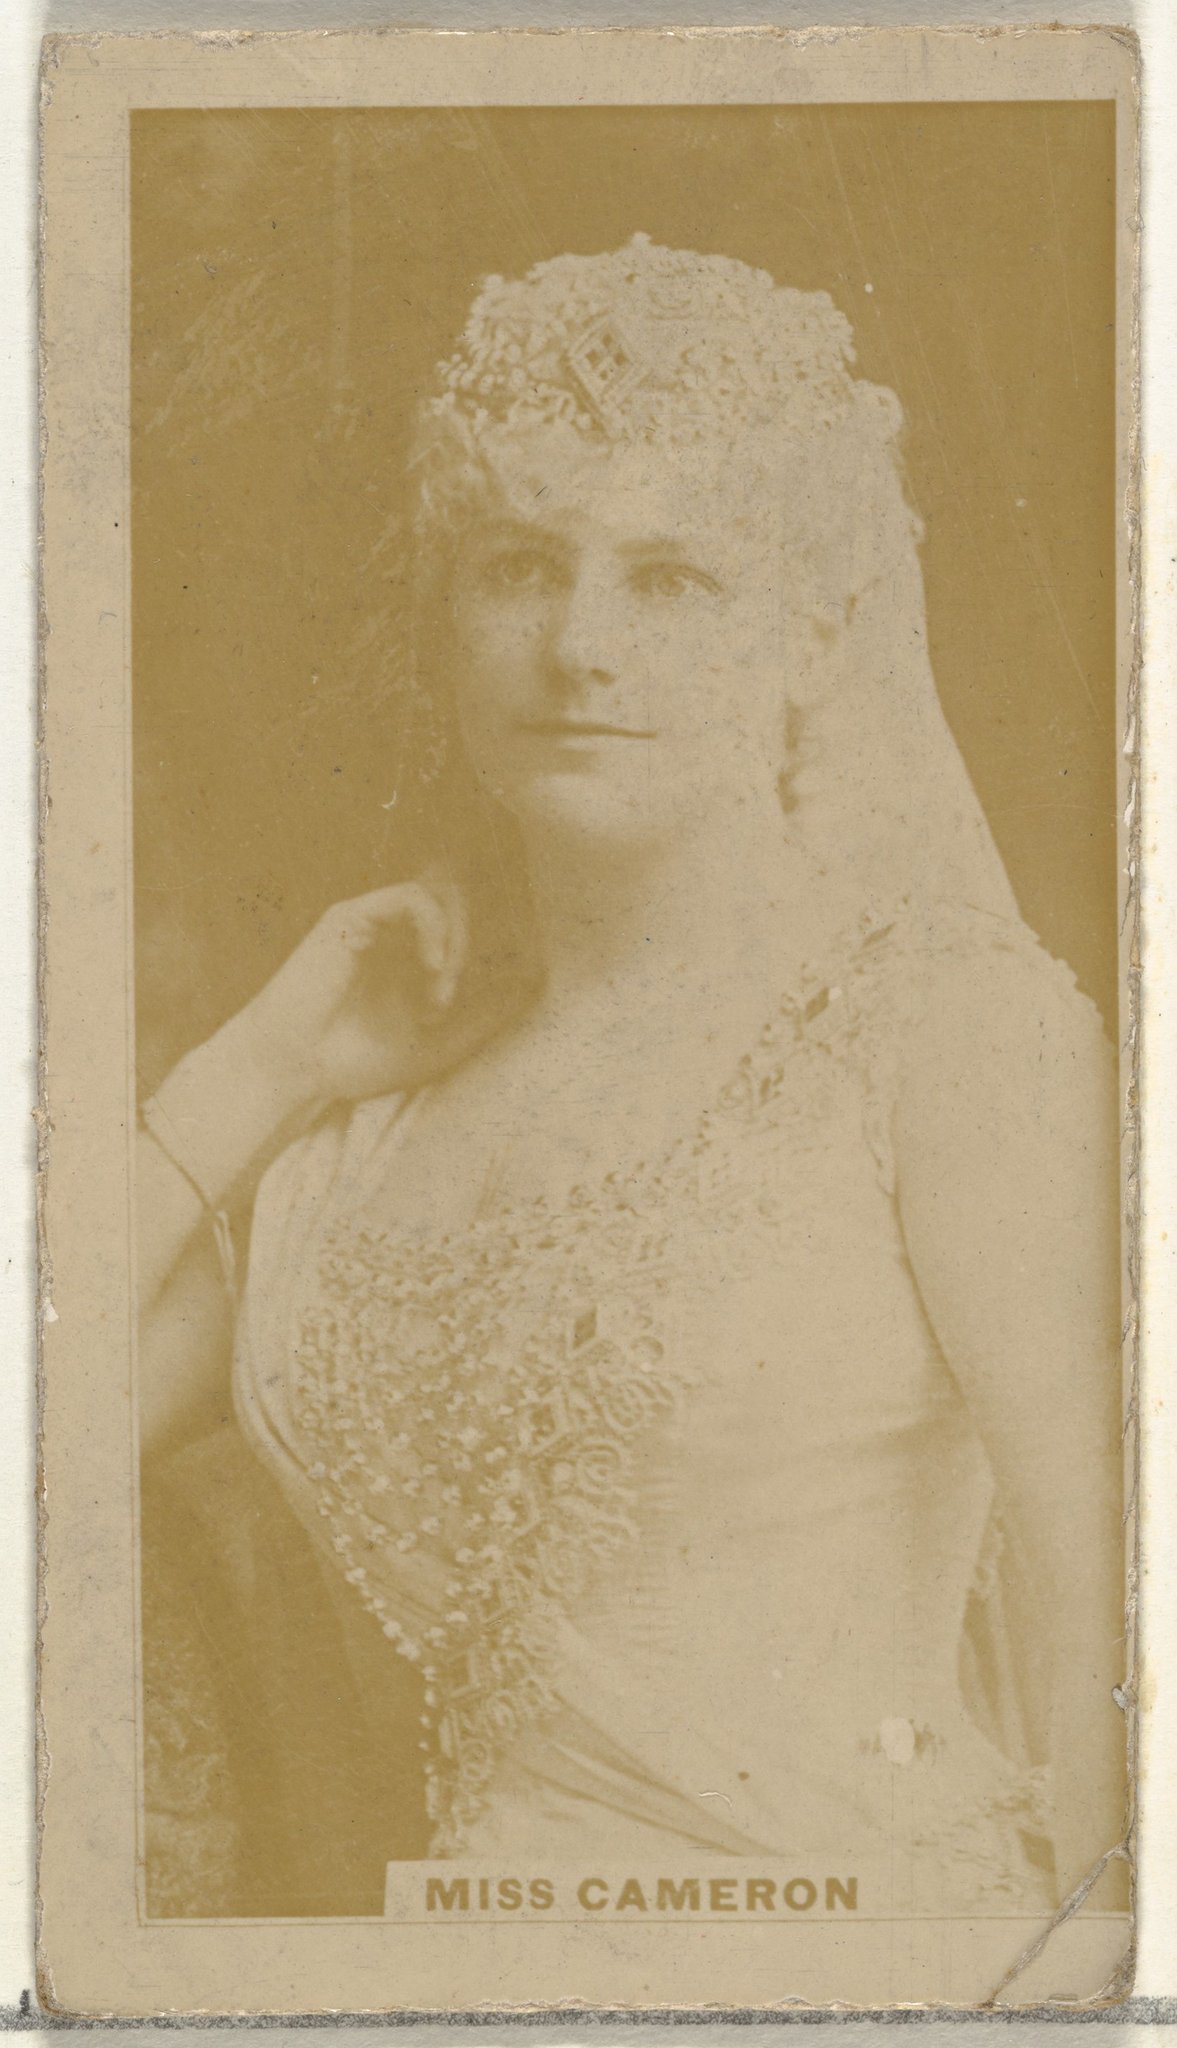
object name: photograph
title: Miss Cameron, from the Actors and Actresses series (N145-8) issued by Duke Sons & Co. to promote Duke Cigarettes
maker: w. duke, sons & co.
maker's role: publisher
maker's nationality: american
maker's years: 1870-1920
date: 1891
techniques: albumen silver print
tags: portraits,women,actresses